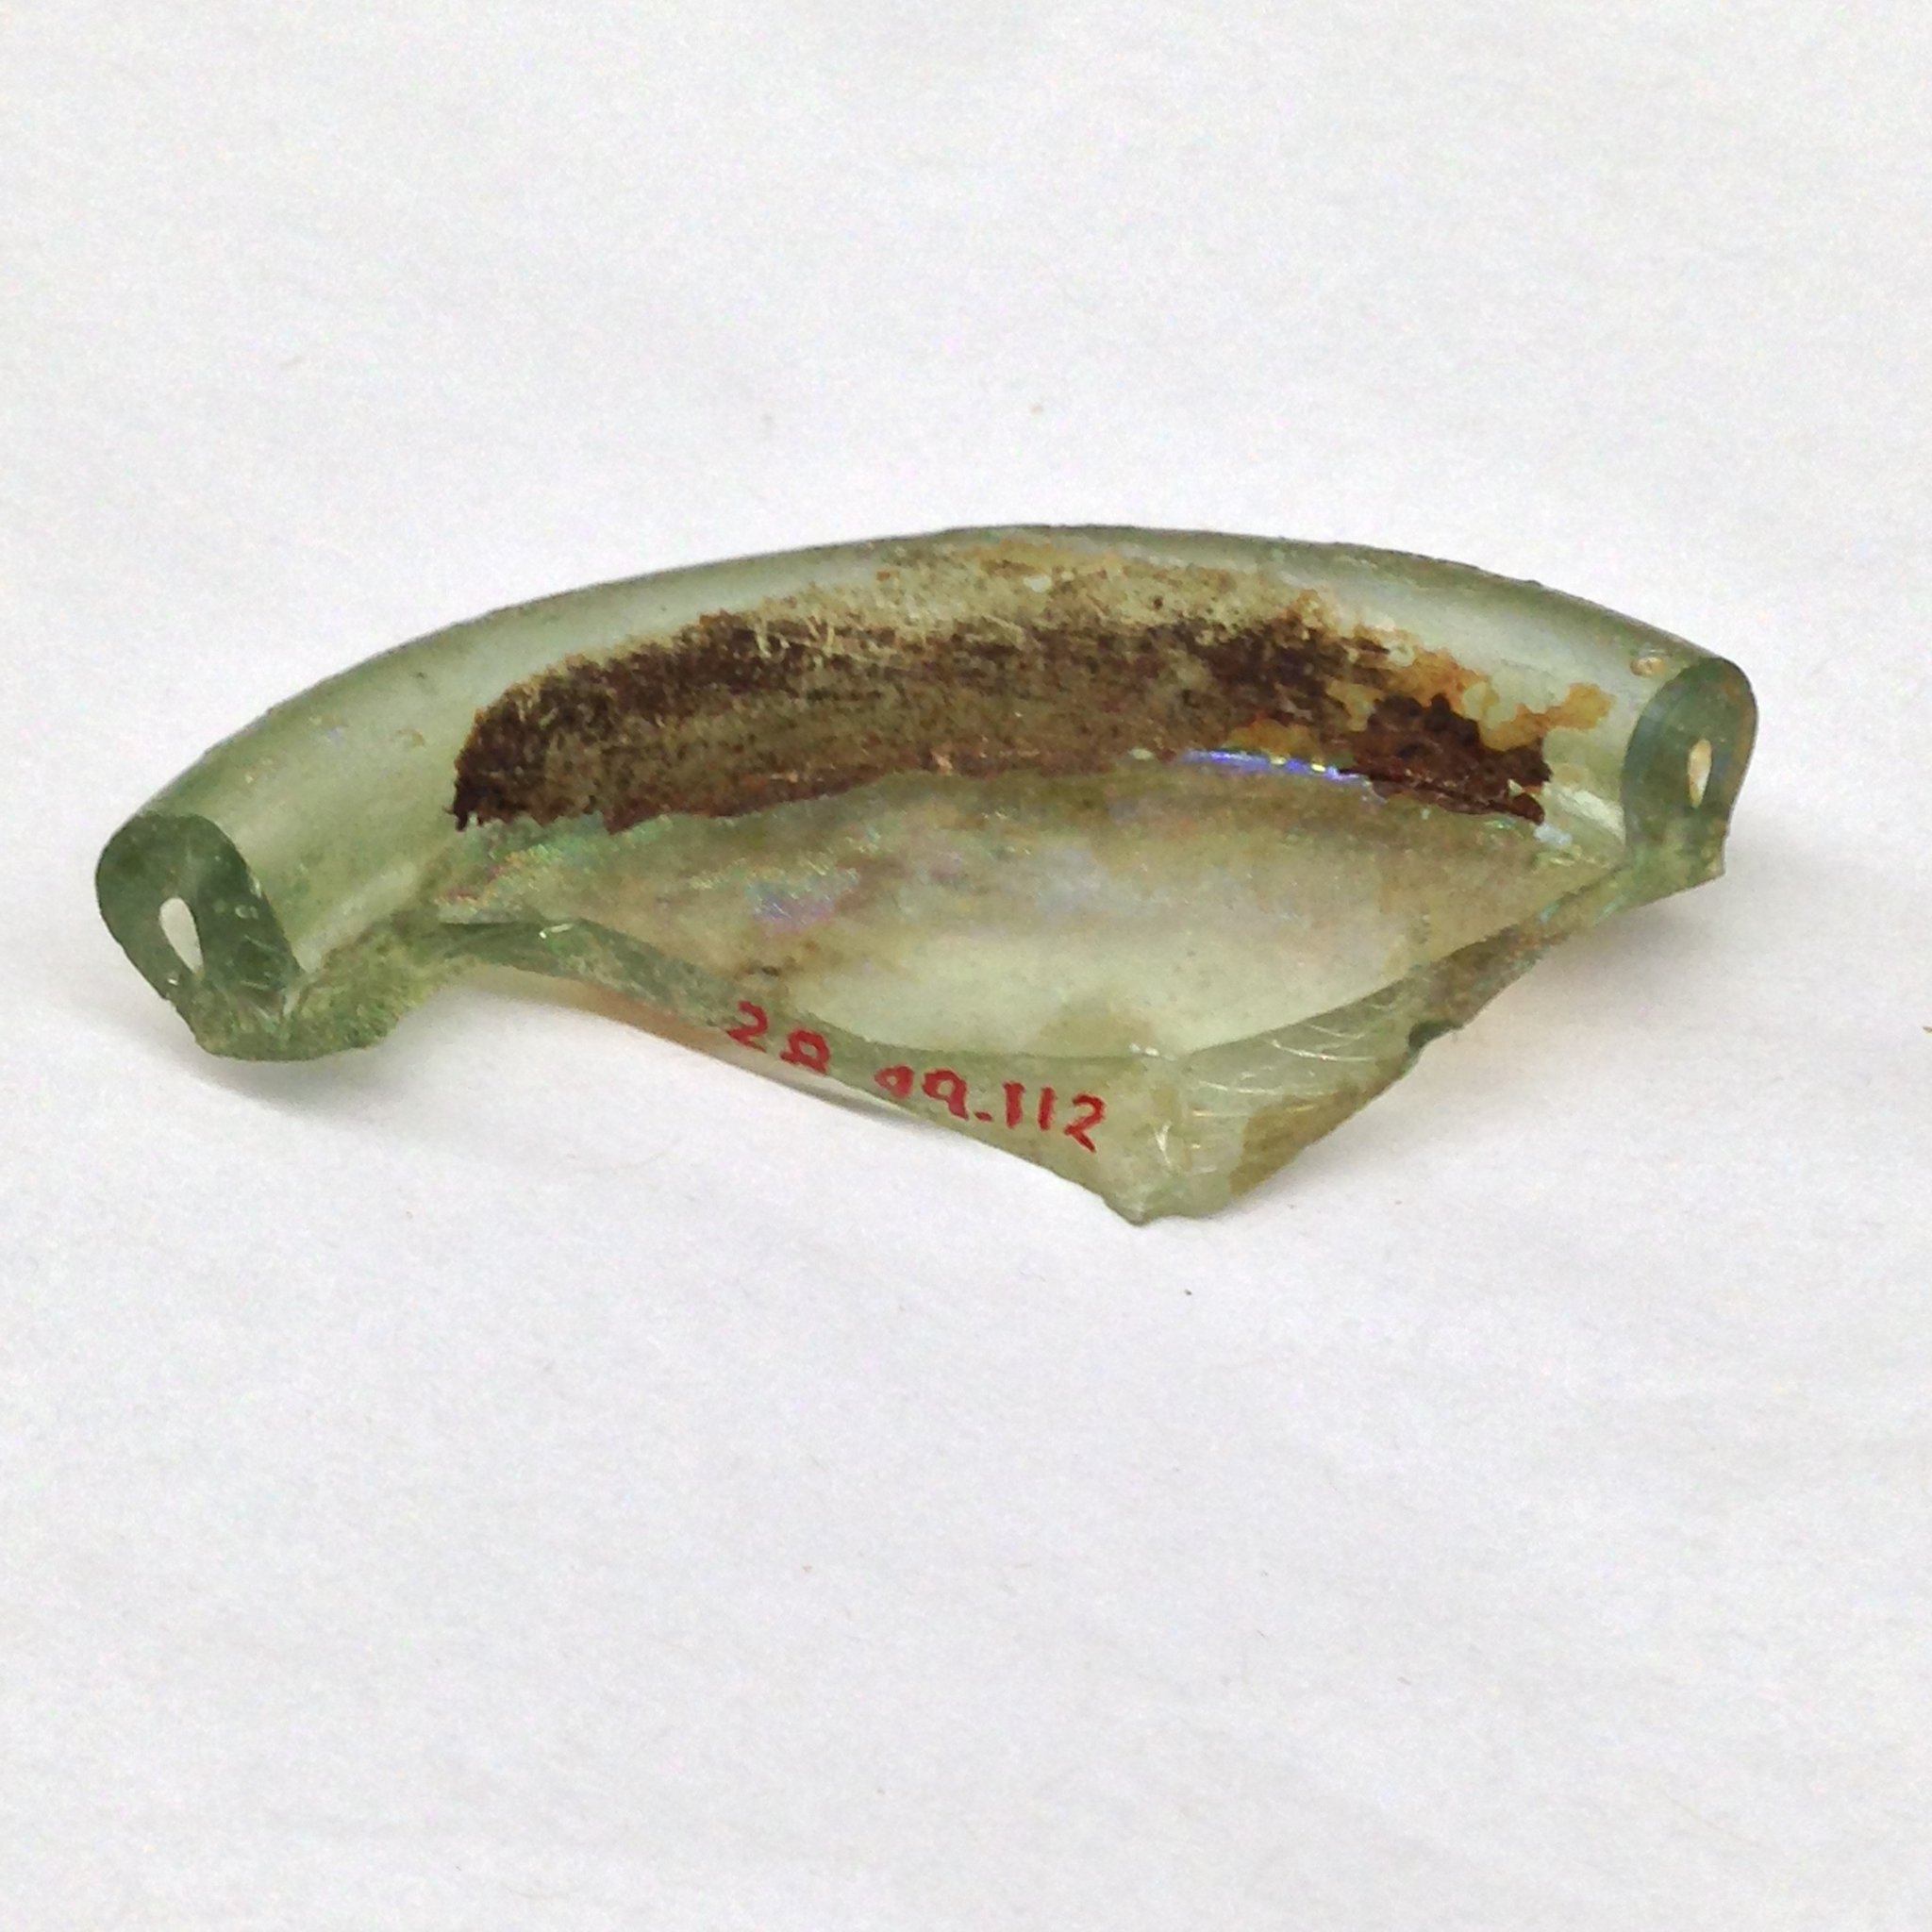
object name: fragment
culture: european or middle eastern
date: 1150-1250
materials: ceramic, glass